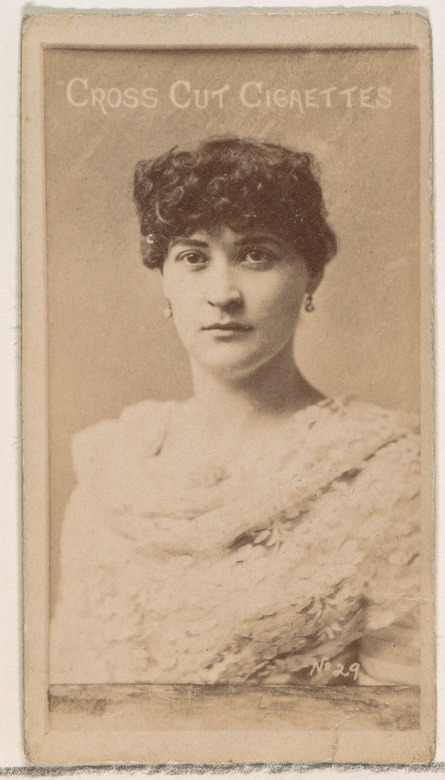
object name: print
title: Card Number 29, from the Actors and Actresses series (N145-1) issued by Duke Sons & Co. to promote Cross Cut Cigarettes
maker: w. duke, sons & co.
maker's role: publisher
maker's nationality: american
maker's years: 1870-1920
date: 1880-1889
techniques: albumen silver print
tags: portraits,women,actresses